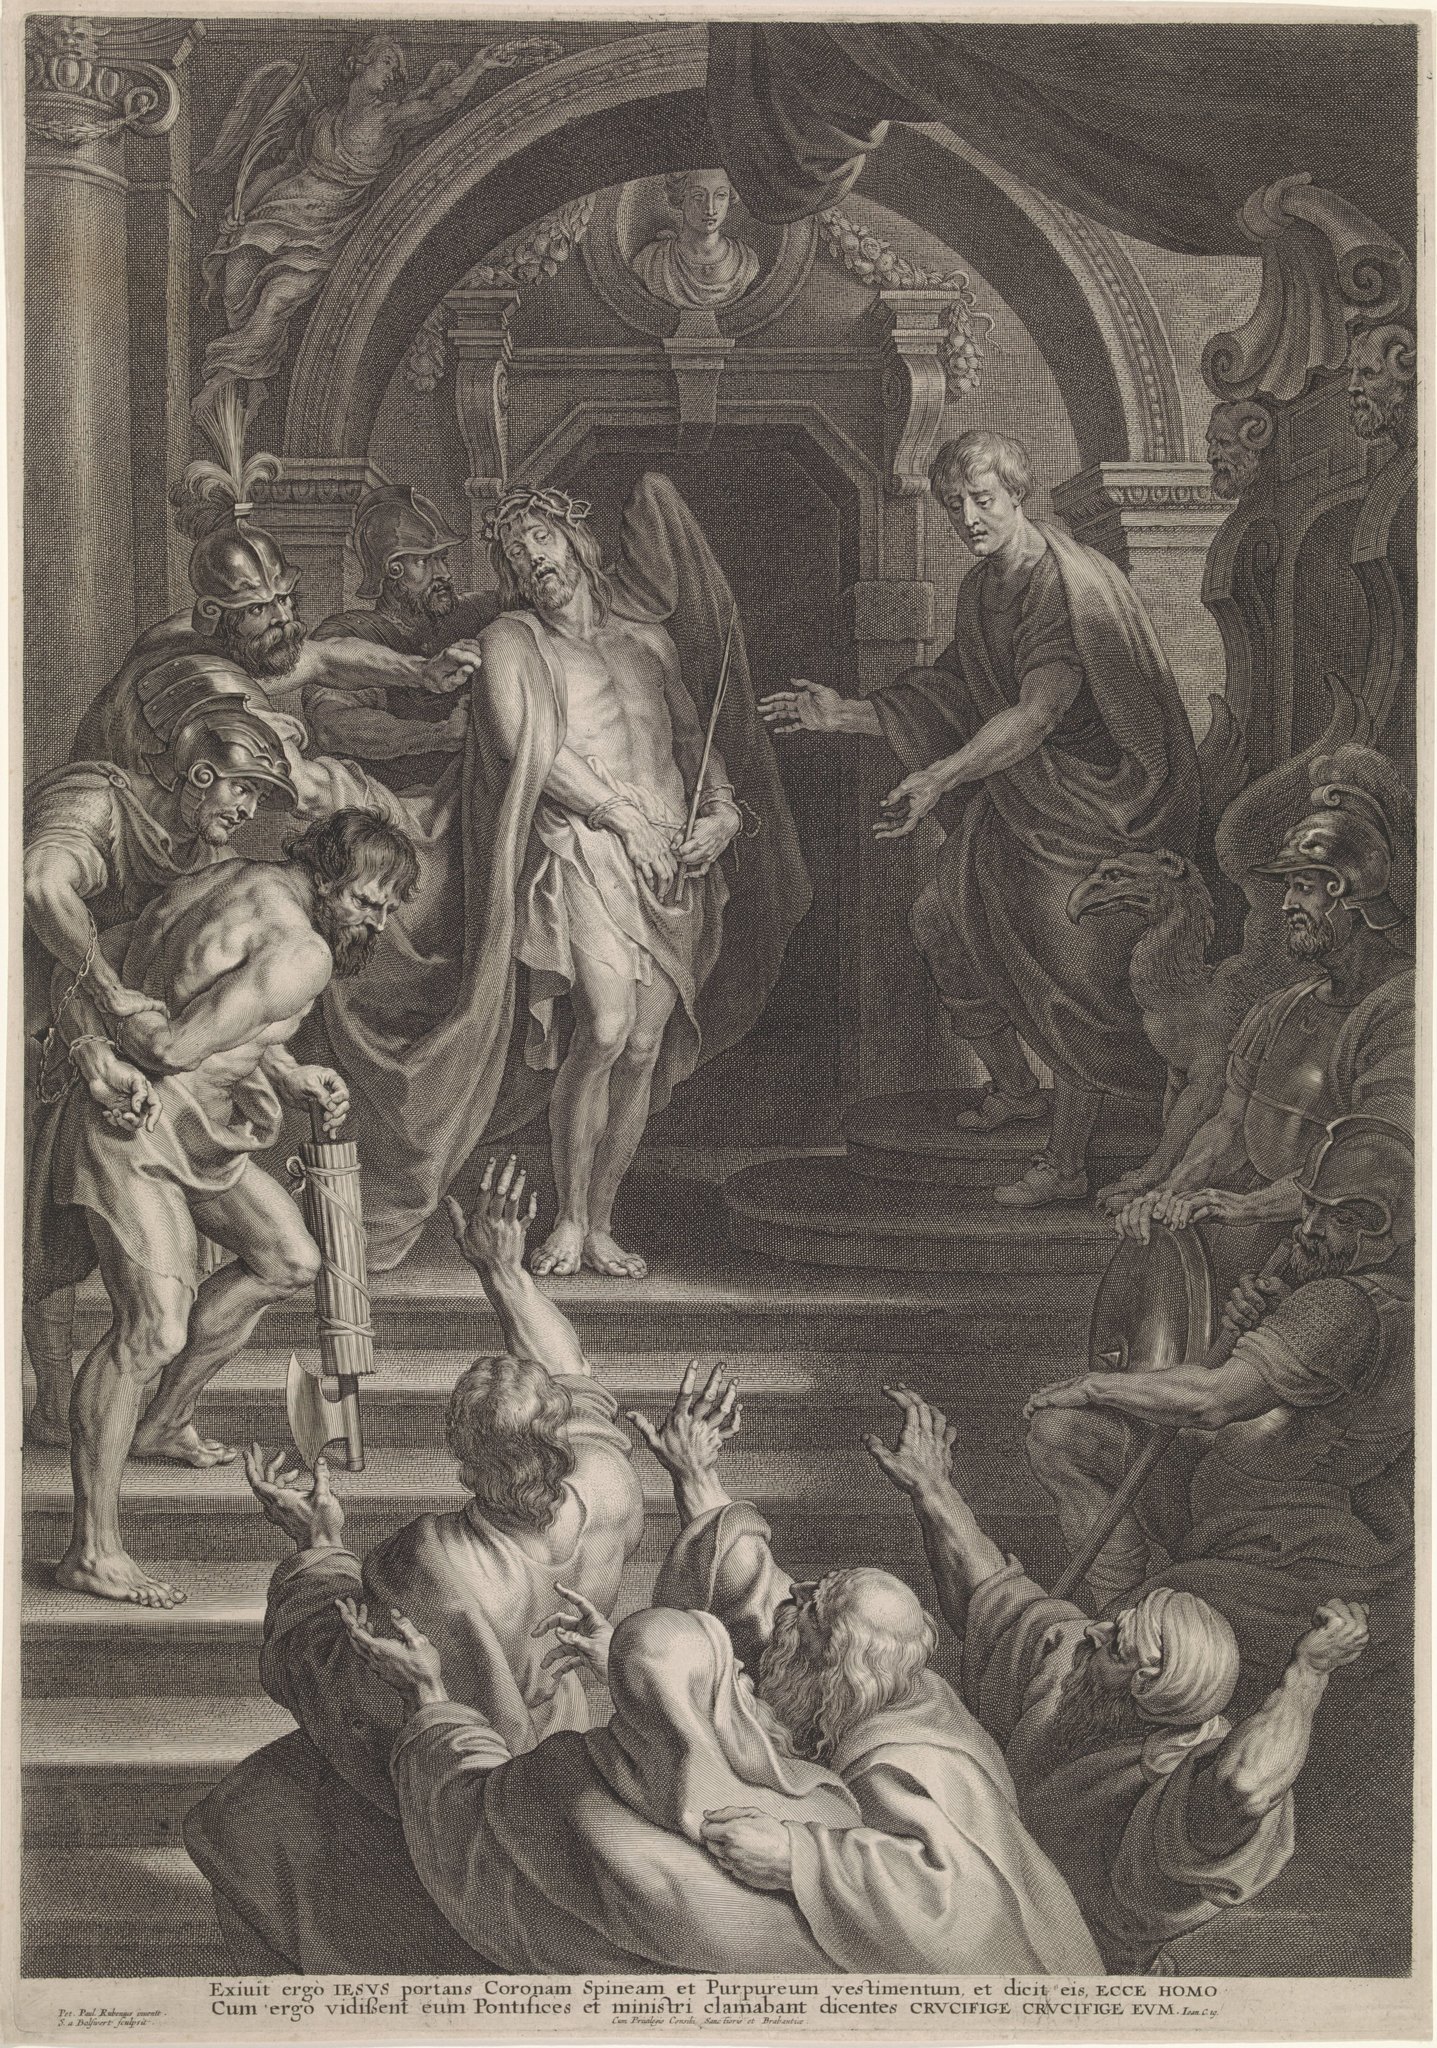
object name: print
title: Ecce Homo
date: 1596-1659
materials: paper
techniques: engraving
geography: netherlands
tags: pilate showing christ to the people, 'ostentatio christi', 'ecce homo' (john 19:4-6)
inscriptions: collector's mark: Lugt 2228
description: Pontius Pilatus toont Christus aan de joden voor het gerechtsgebouw. De hogepriesters schreeuwen om zijn kruisiging af te dwingen. In de marge onder staat een fragment uit bijbeltekst Johannes 19.